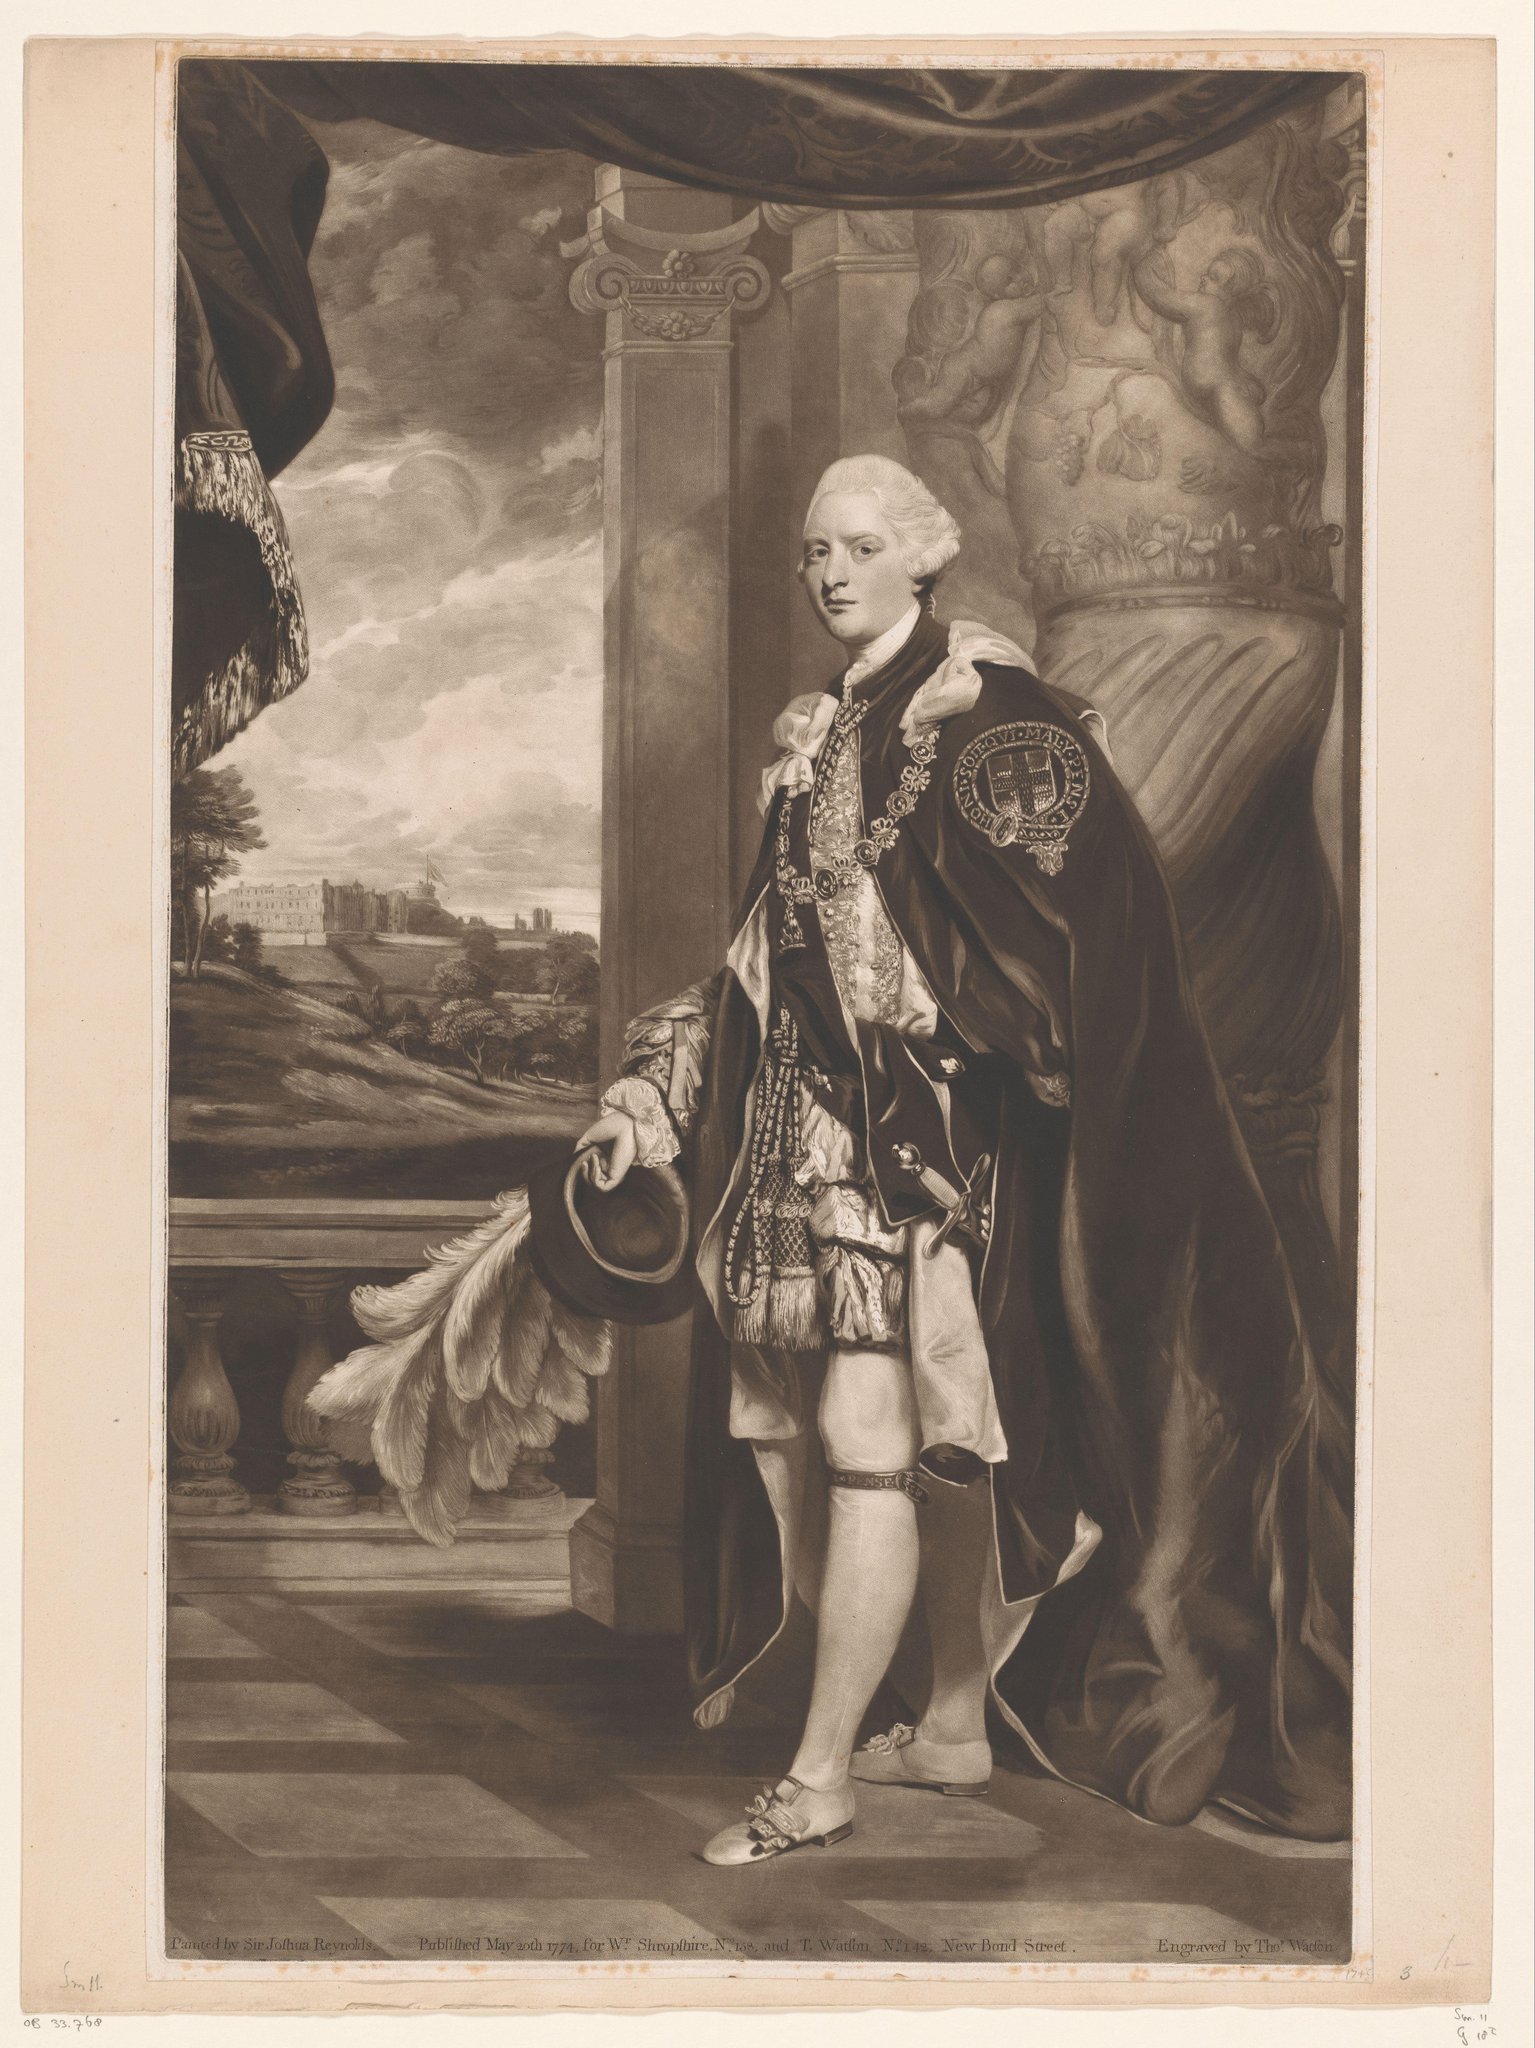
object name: print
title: Portret van Hendrik Frederik van Cumberland en Strathearn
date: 1705-1774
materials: paper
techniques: mezzotint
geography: london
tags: historical persons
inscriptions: collector's mark: Lugt 240